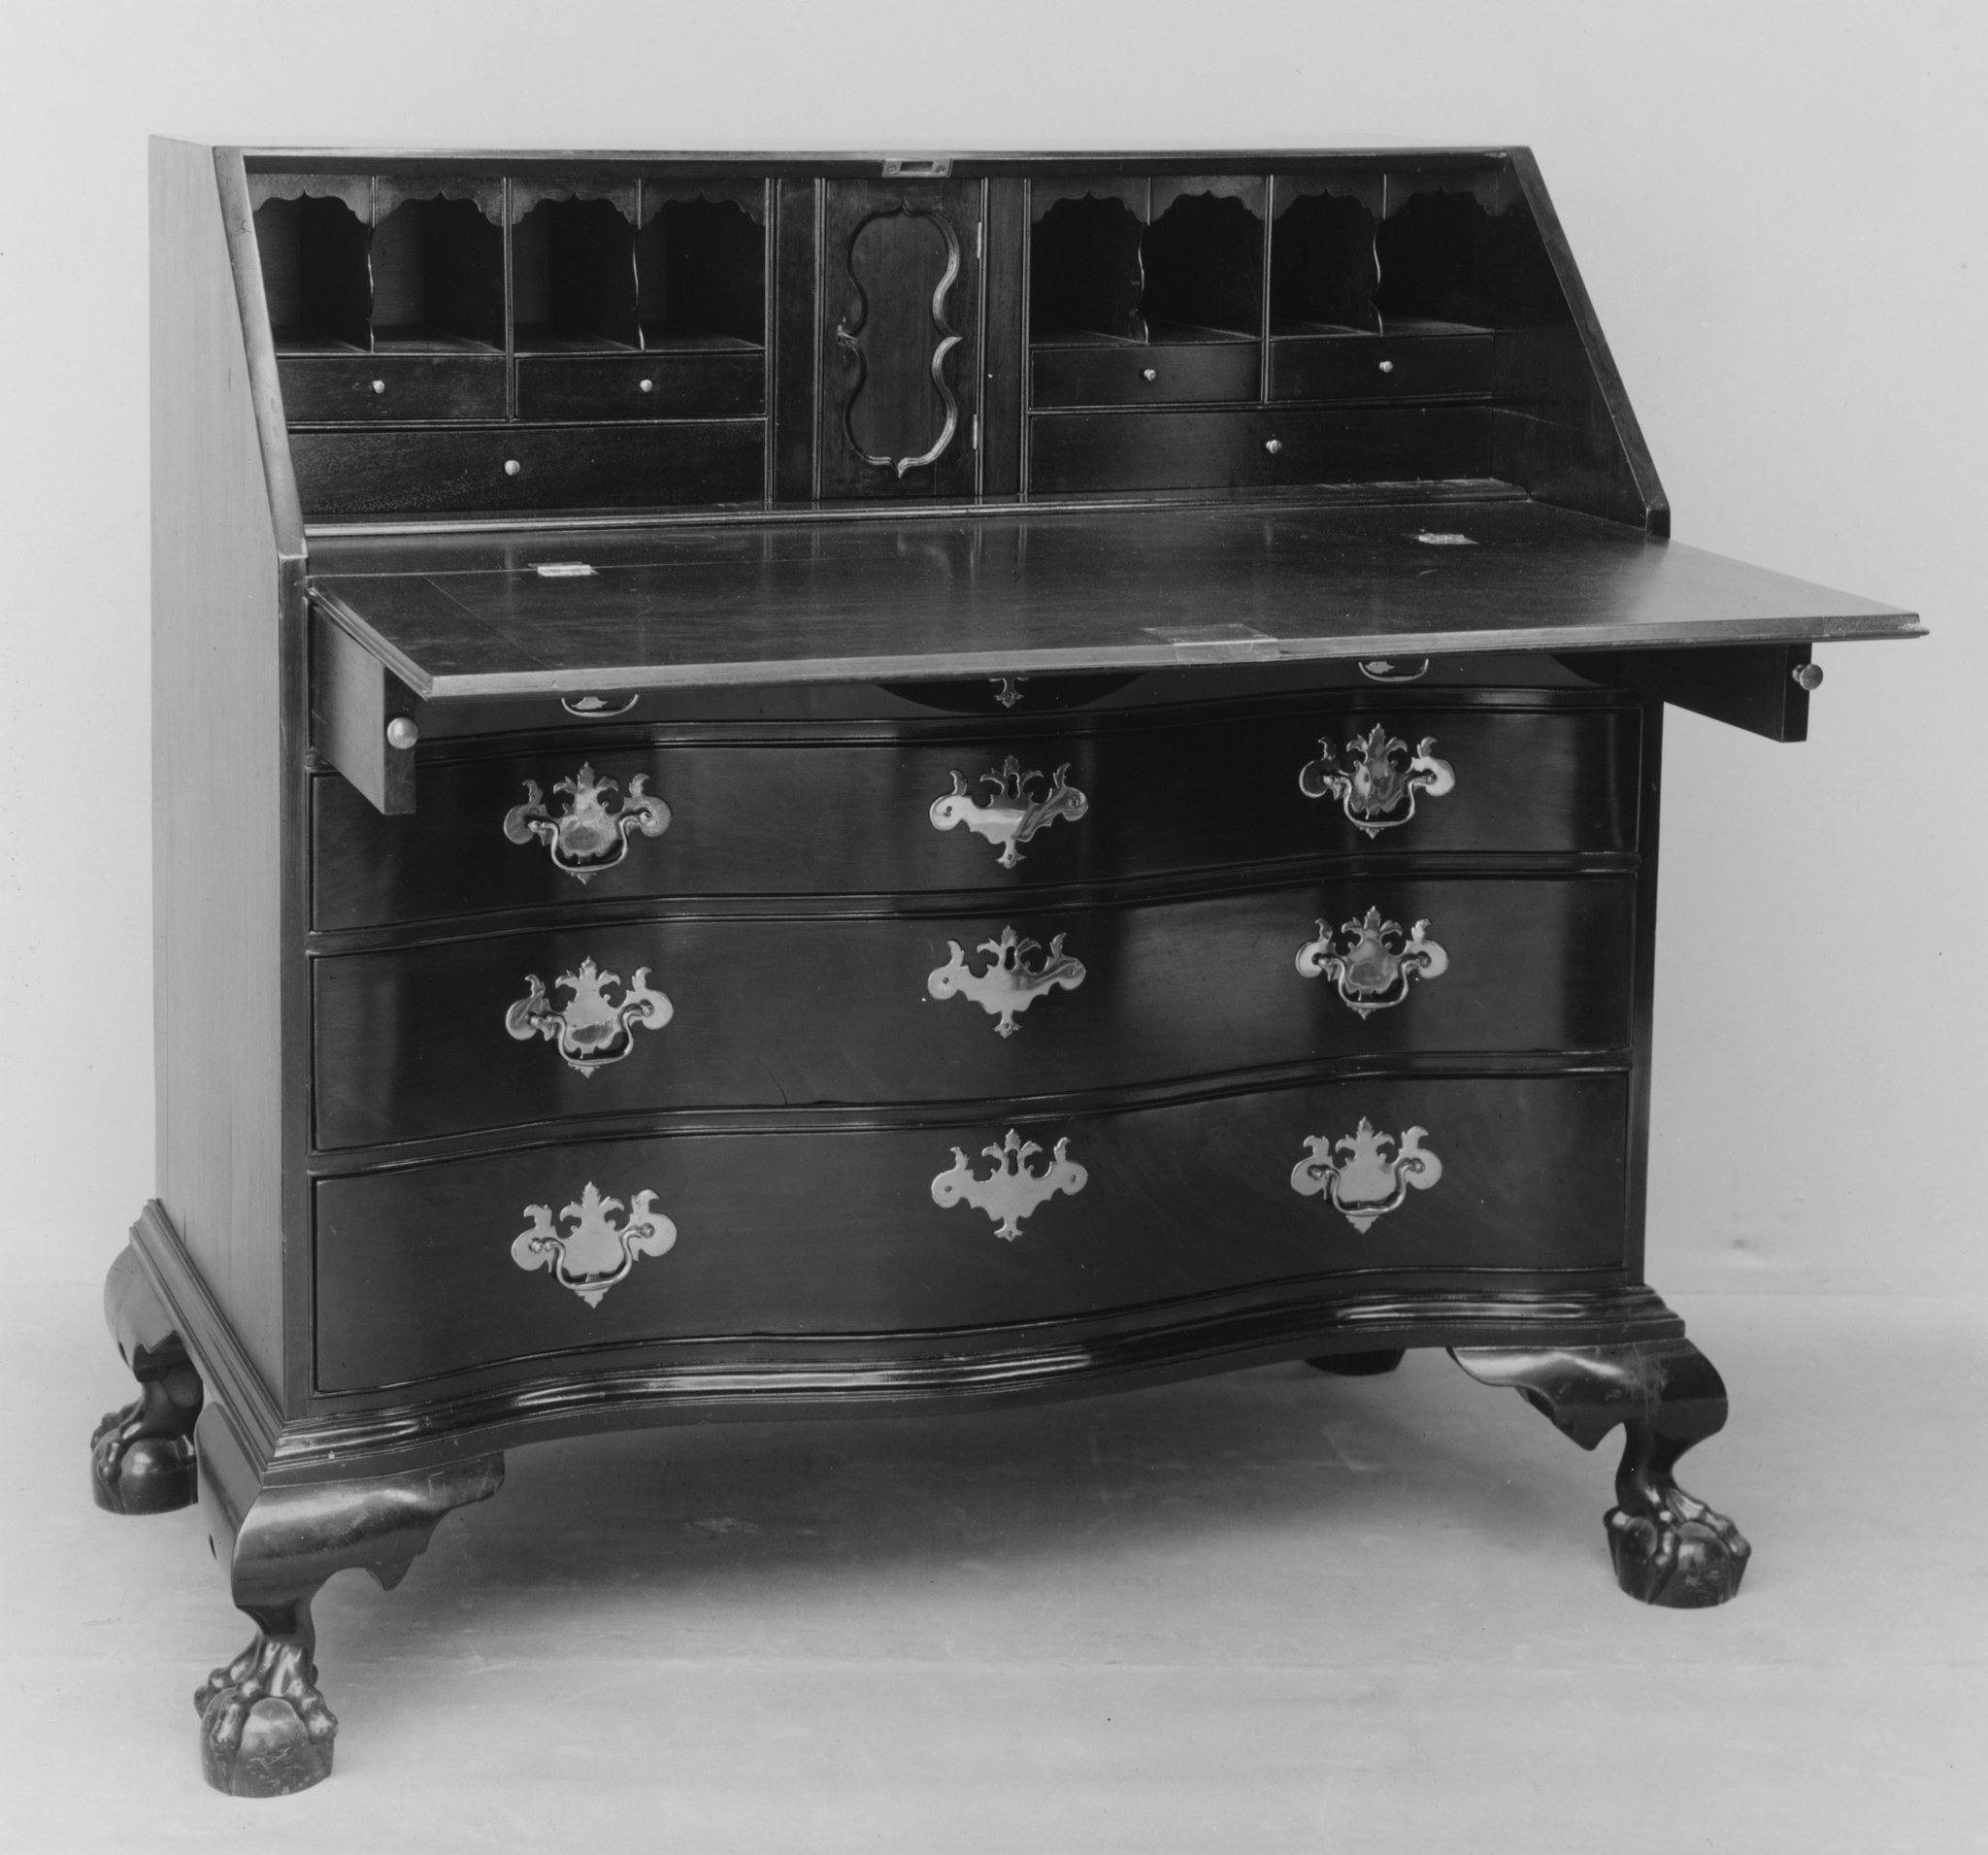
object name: desk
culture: american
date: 1760-1790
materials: wood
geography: united states